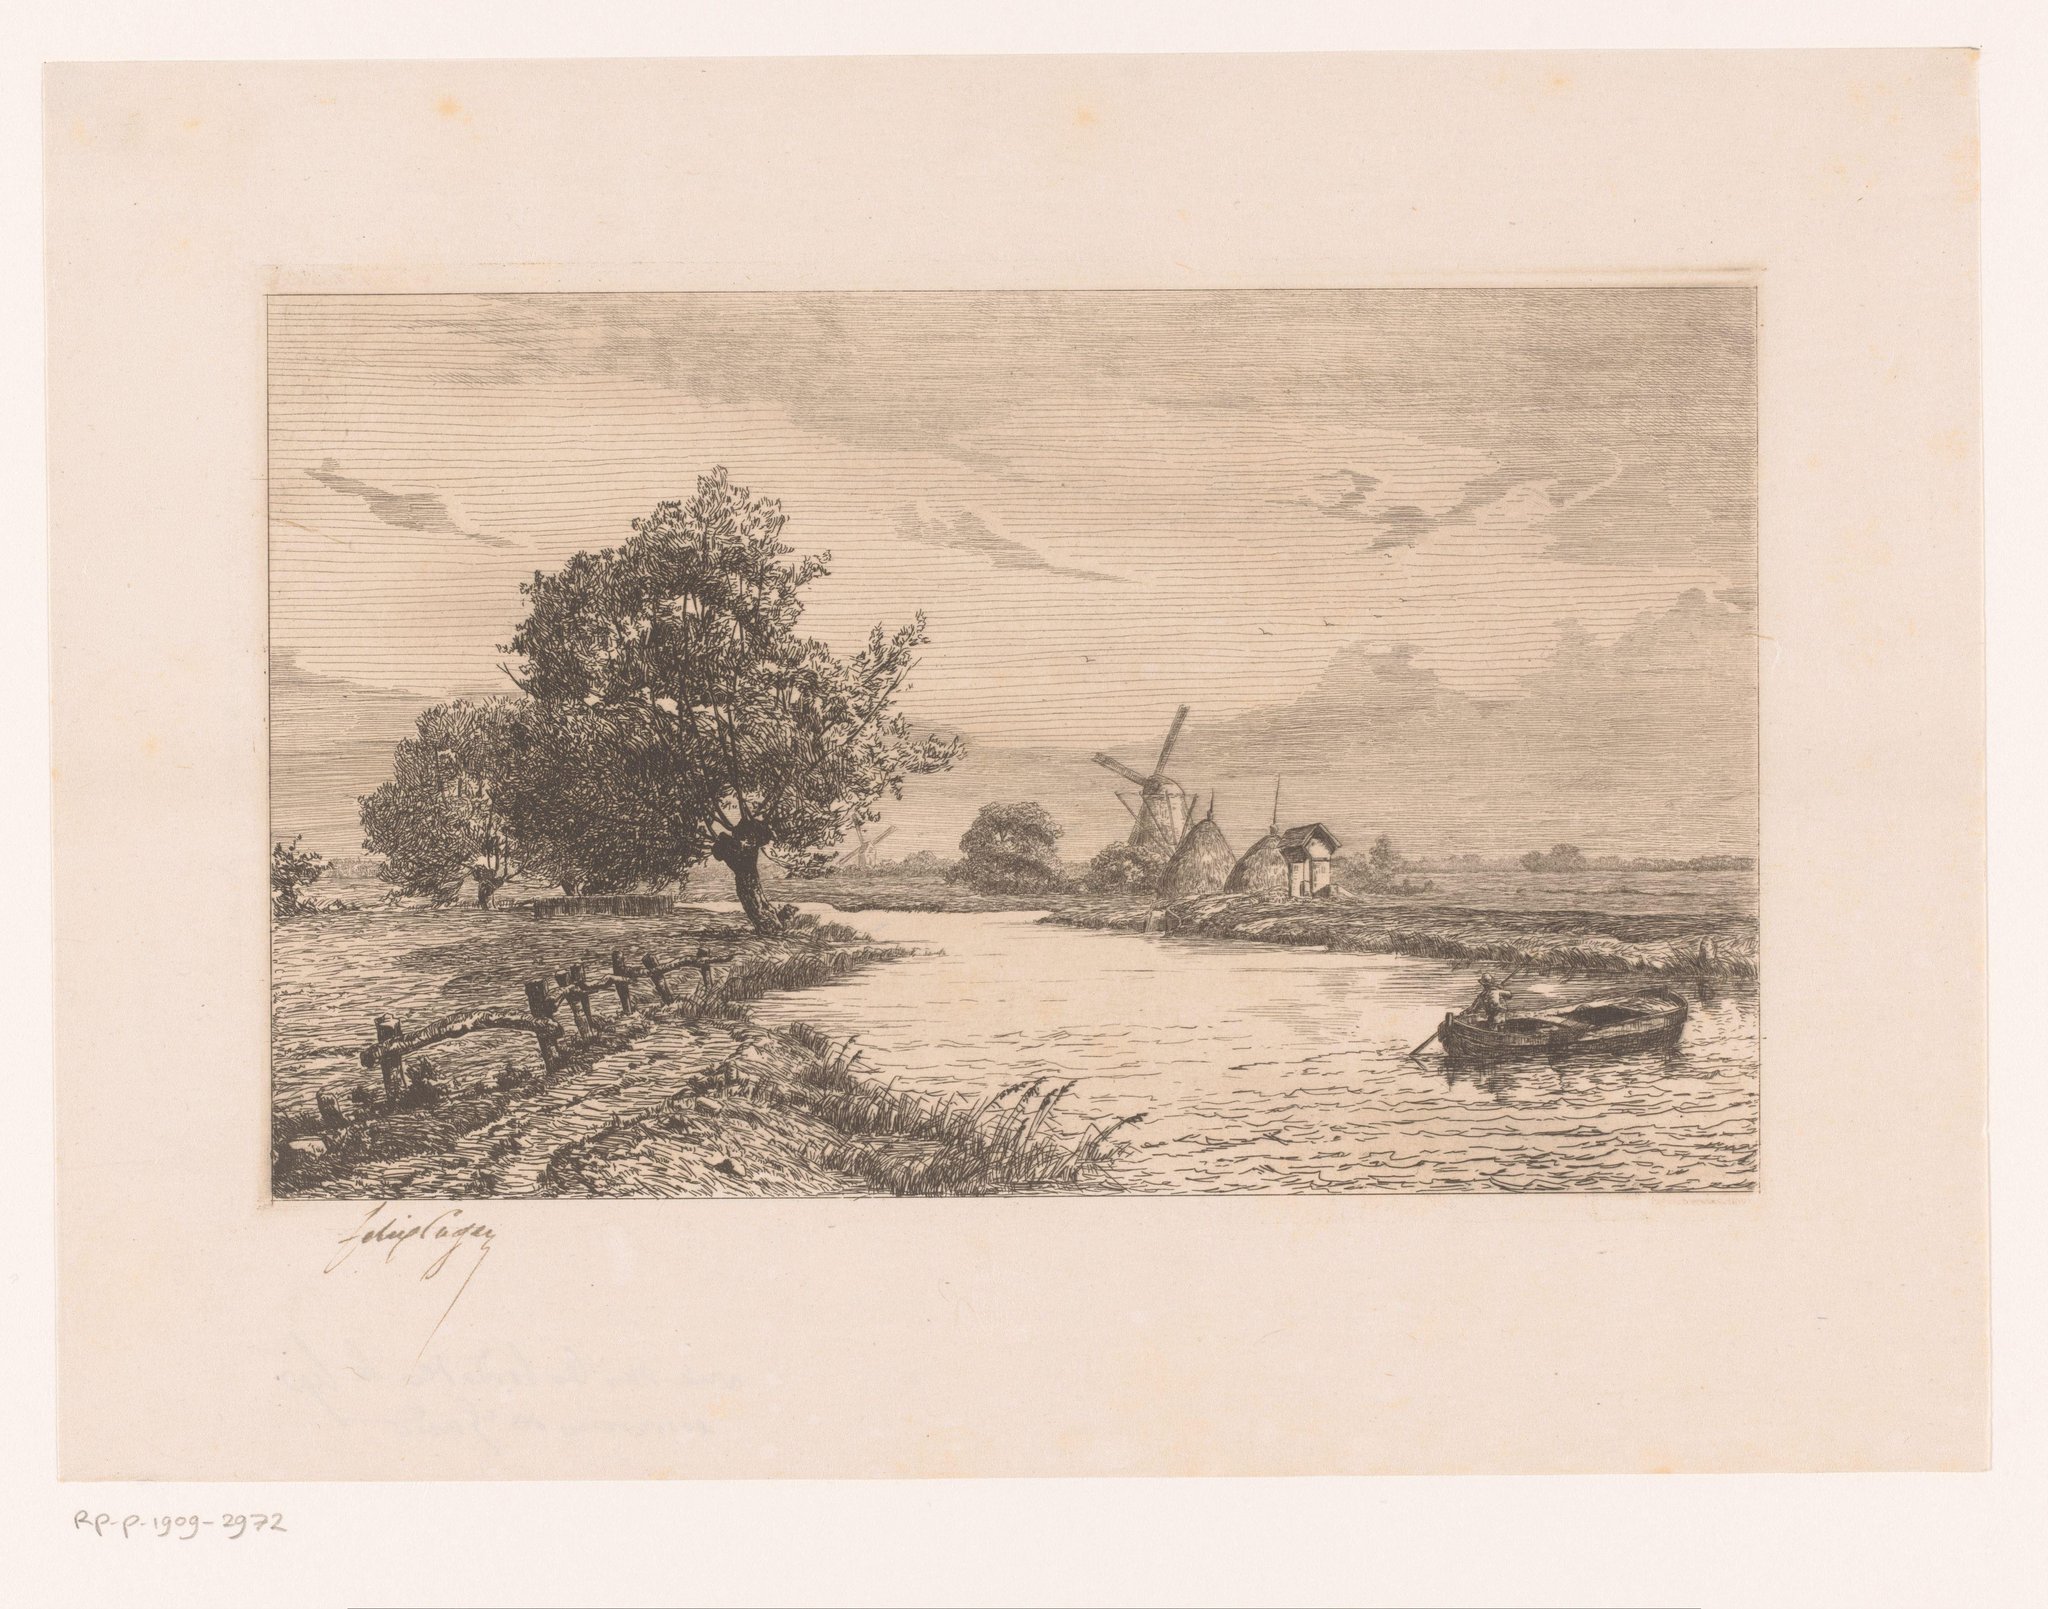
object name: print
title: Gezicht op rivier de Leie in de omgeving van Gent met molens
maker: félix cogen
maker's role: print maker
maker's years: 1838-1907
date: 1848-1907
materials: paper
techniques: etching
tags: river, rowing-boat, canoe, etc., windmill in landscape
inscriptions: collector's mark: Lugt 2228, mark: ‘Antwerpsche Etsers 1880’